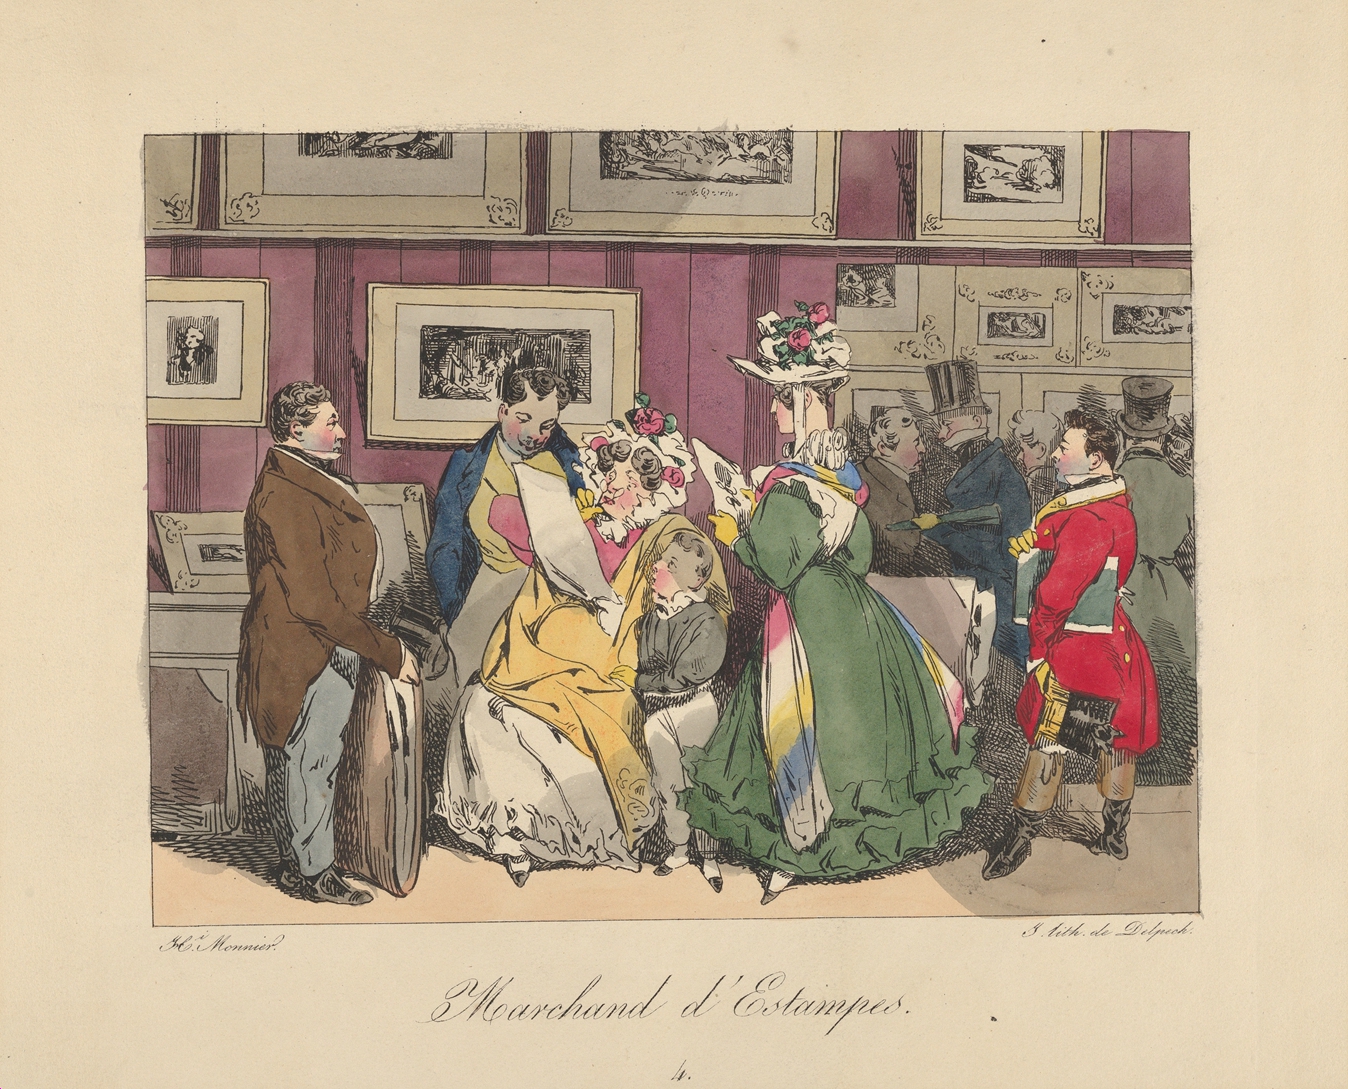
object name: print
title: Print Dealer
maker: henry-bonaventure monnier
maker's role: artist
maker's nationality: french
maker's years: 1799-1877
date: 1820-1830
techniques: hand coloring, lithograph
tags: men,women